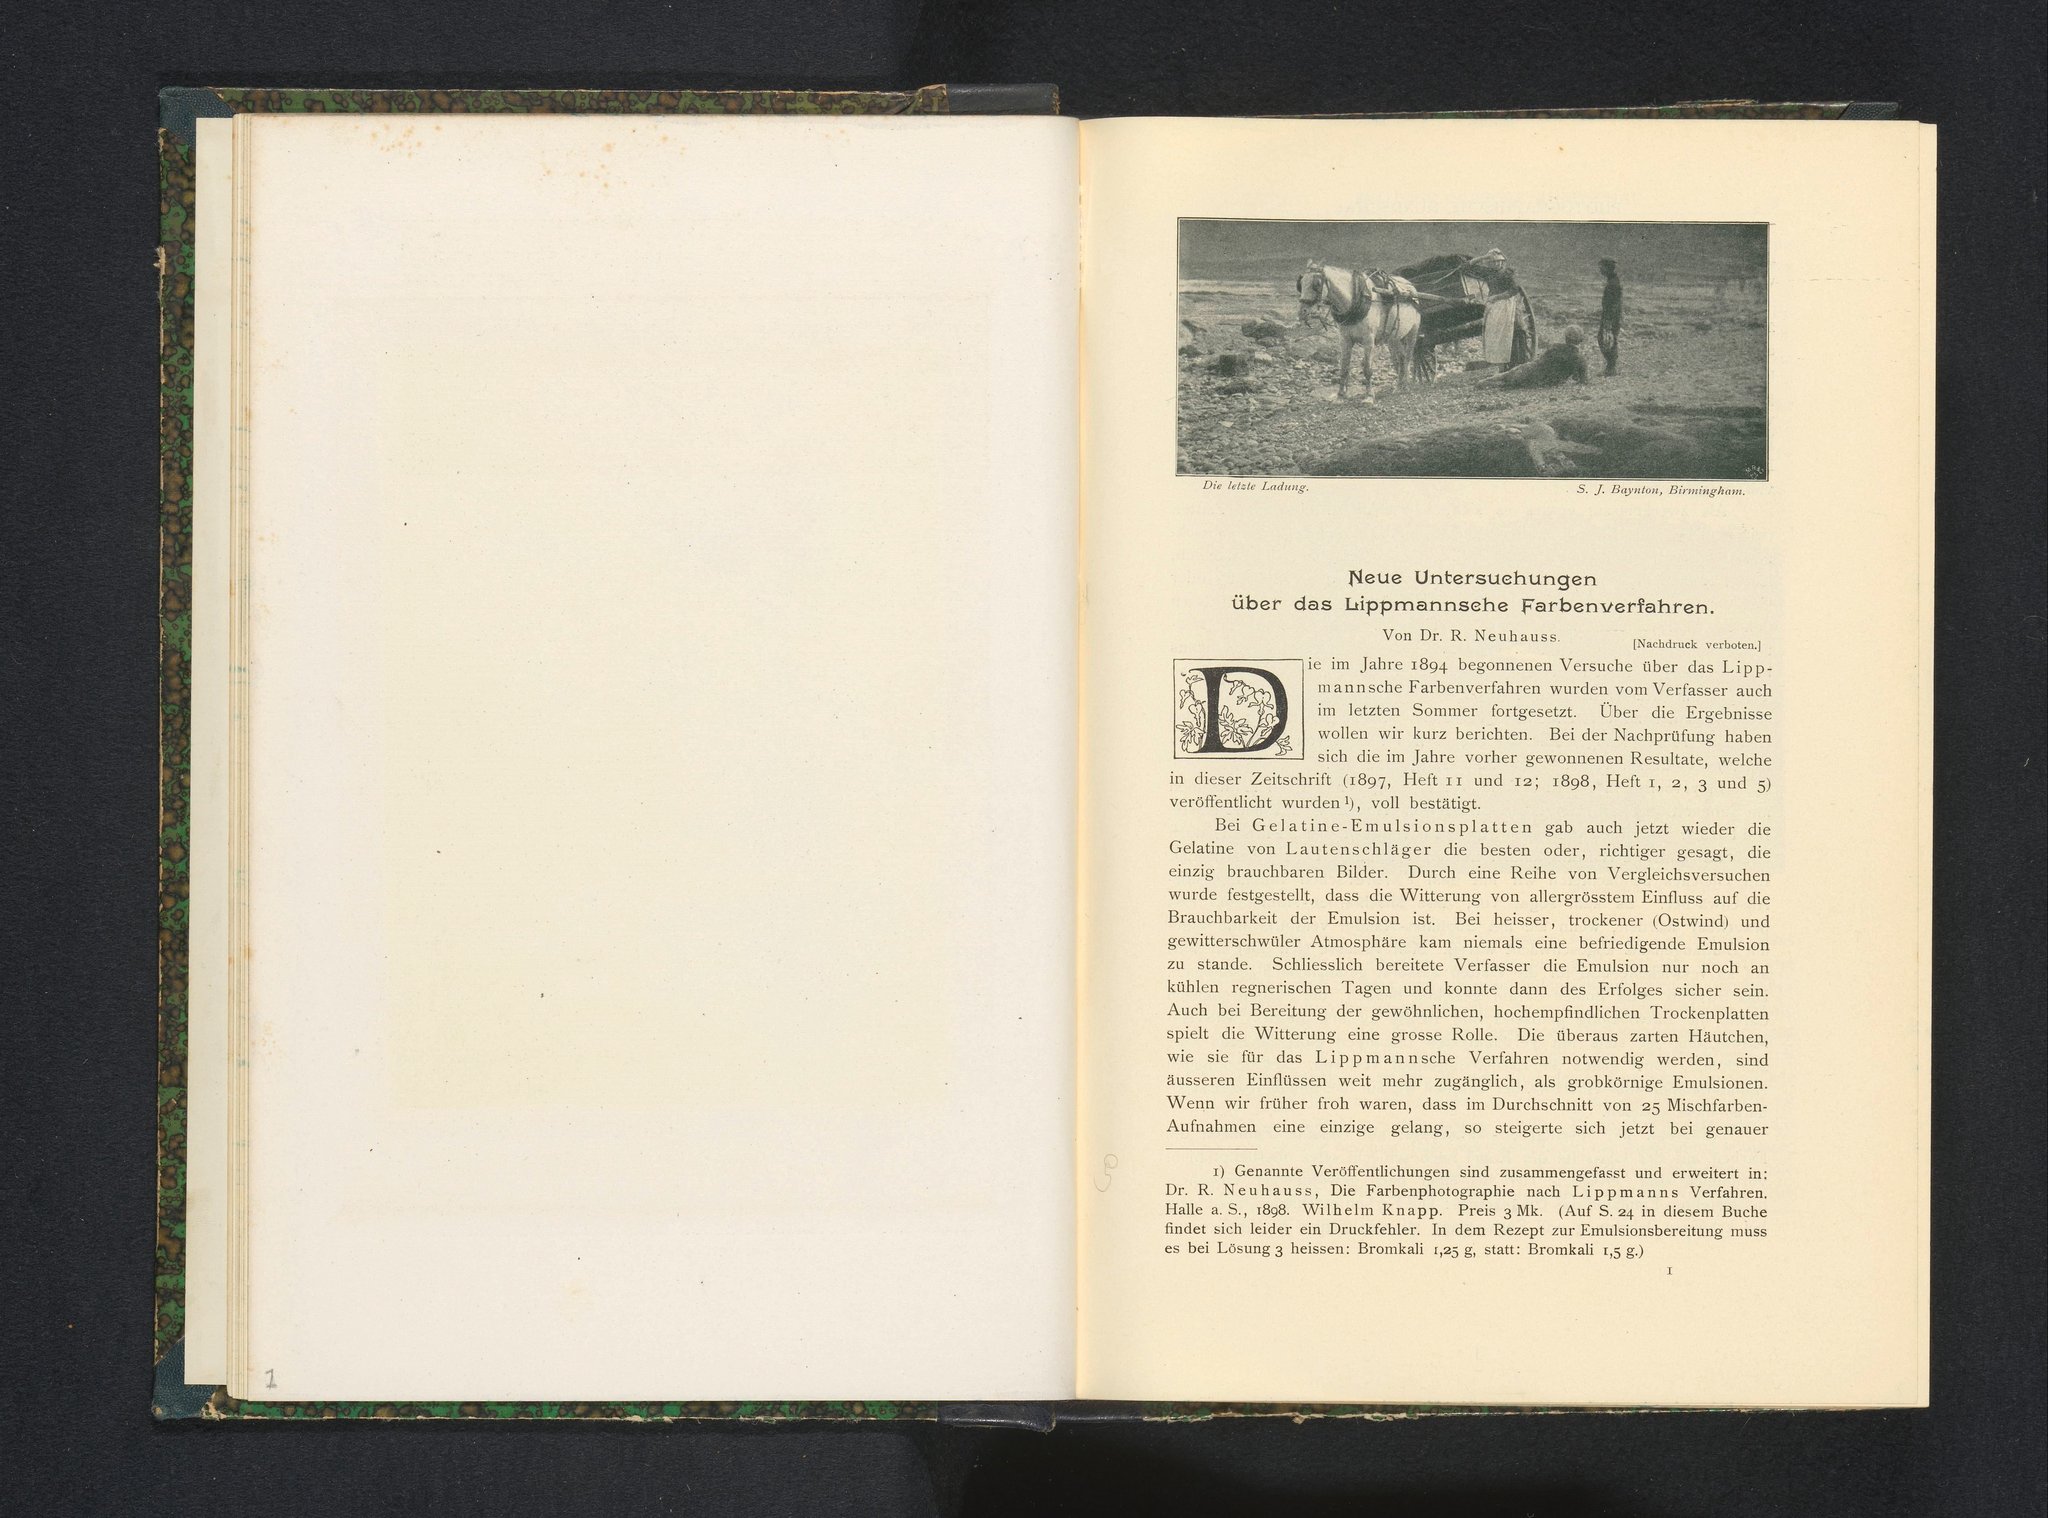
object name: photomechanical print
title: Die letzte Ladung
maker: c. j. baynton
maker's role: fotograaf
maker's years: 1866-1924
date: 1894-1899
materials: paper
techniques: autotype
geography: berlin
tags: harvest, horse